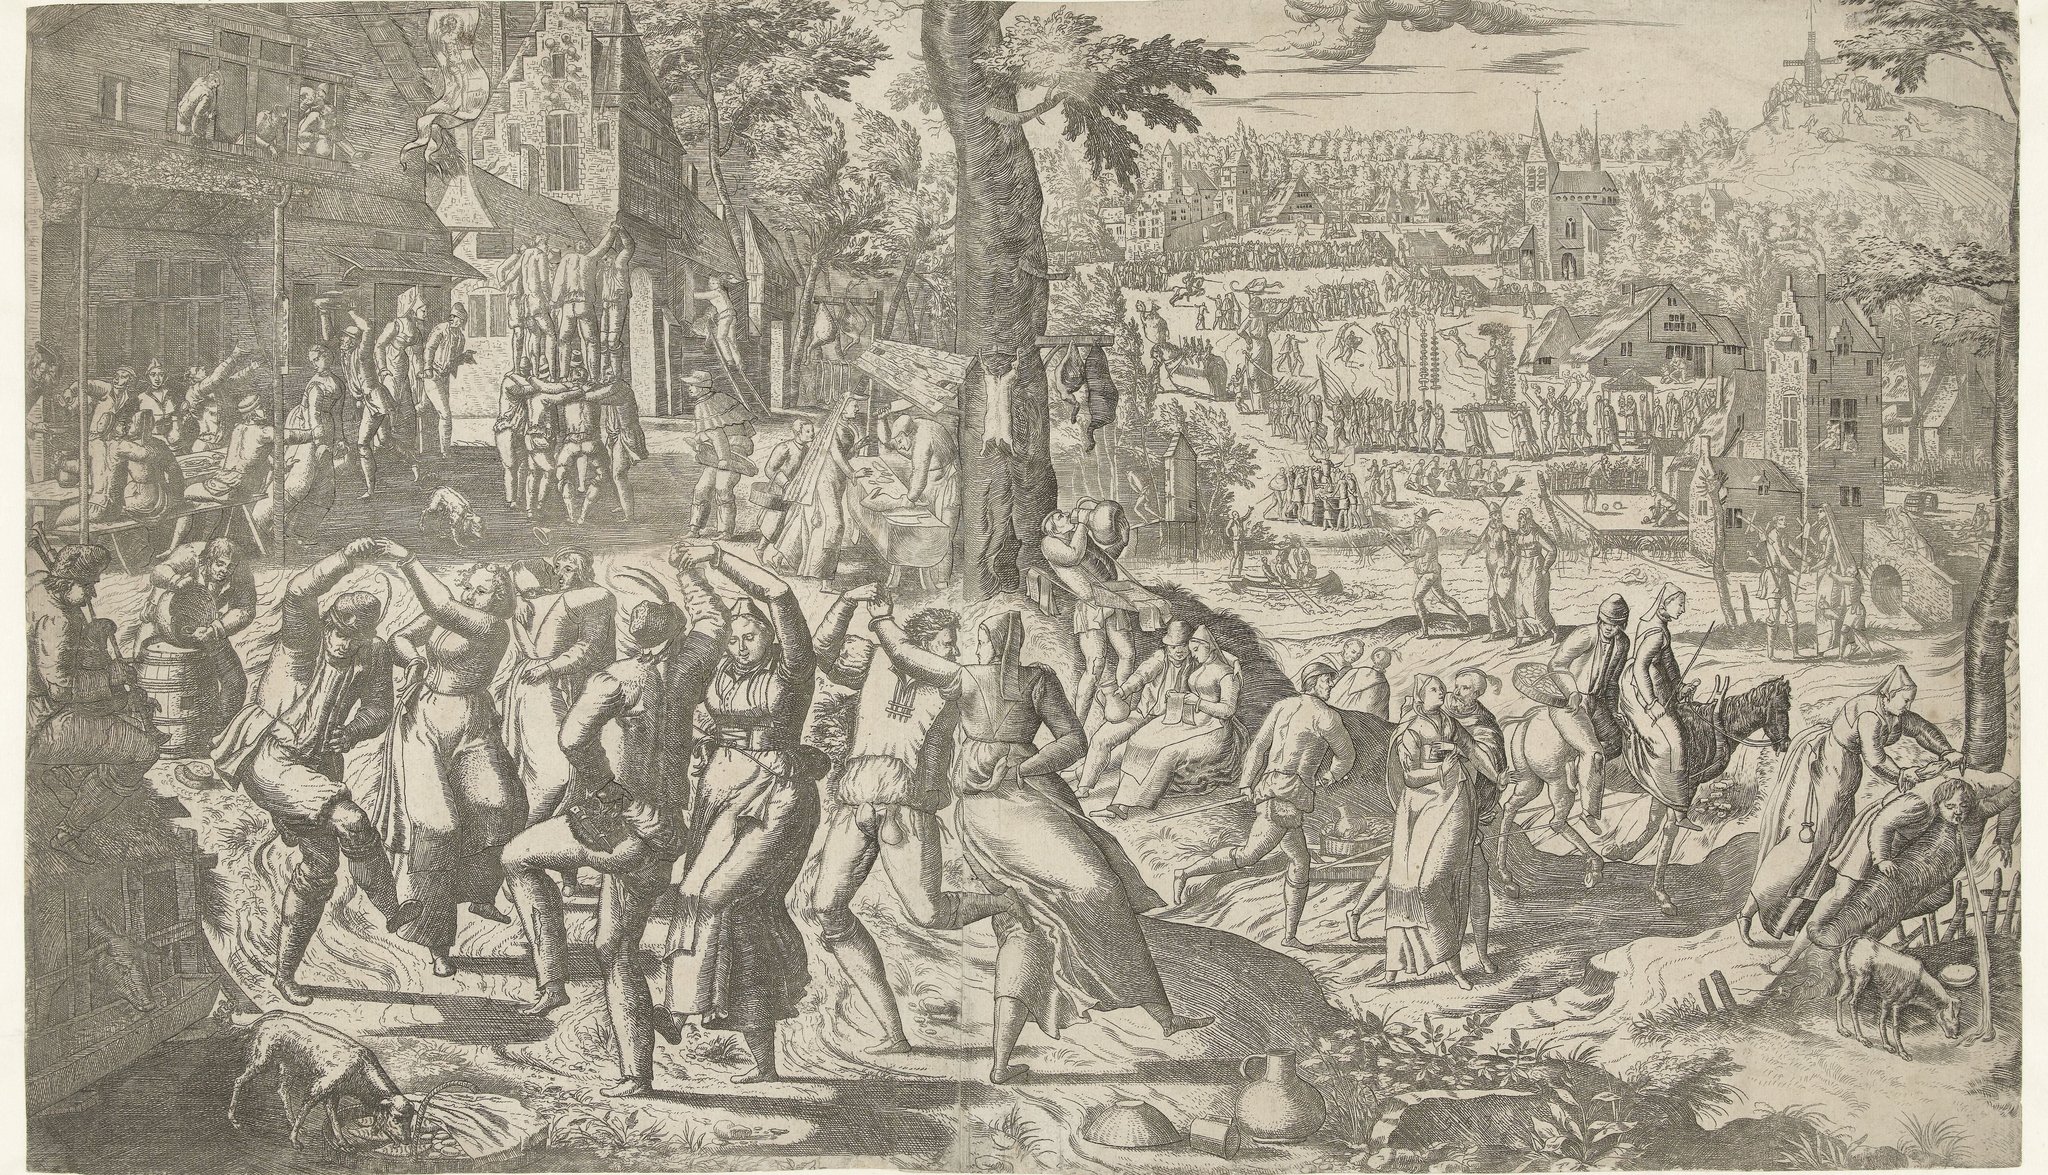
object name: print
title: Sint-Joris kermis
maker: pieter van der borcht (i)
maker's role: print maker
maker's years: 1545-1608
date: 1553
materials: paper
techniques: etching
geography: antwerp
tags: other forms of knights' contests, (annual) fair, trade fair, vomiting, inn, coffee-house, public house, etc., joust, tilt, 'jeu de boules', pleasure fair and circus, more than one couple dancing (with number of couples), procession ~ christian religion, shooting-the-bird (on a high pole)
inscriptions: collector's mark: Lugt 2228, collector's mark: Lugt 2760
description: Dorpskermis ter ere van Sint-Joris. Op de voorgrond drie paren die dansen op de muziek van een doedelzakspeler, die in de linkerhoek bovenop het dak van een varkensstal zit. Achter de dansers staat een paar te vrijen. Links bij een herberg wordt gegeten en gedronken. Uit een van de vensters van de herberg hangt het vaandel van de Sint-Jorisgilde der boogschutters. Op de achtergrond wordt er een toren van mensen gebouwd en verkopen allerlei lieden hun waren. Rechts op de voorgrond ligt iemand te braken. Rechts op de achtergrond verschillende kermisattracties rondom een ommegang. De ommegang bevat ondermeer het paard van de vier heemskinderen, een reus en de verering van een heilige. Rondom de processie allerlei spelen: zwaardvechten, het steekspel, boogschieten en jeu de boules.